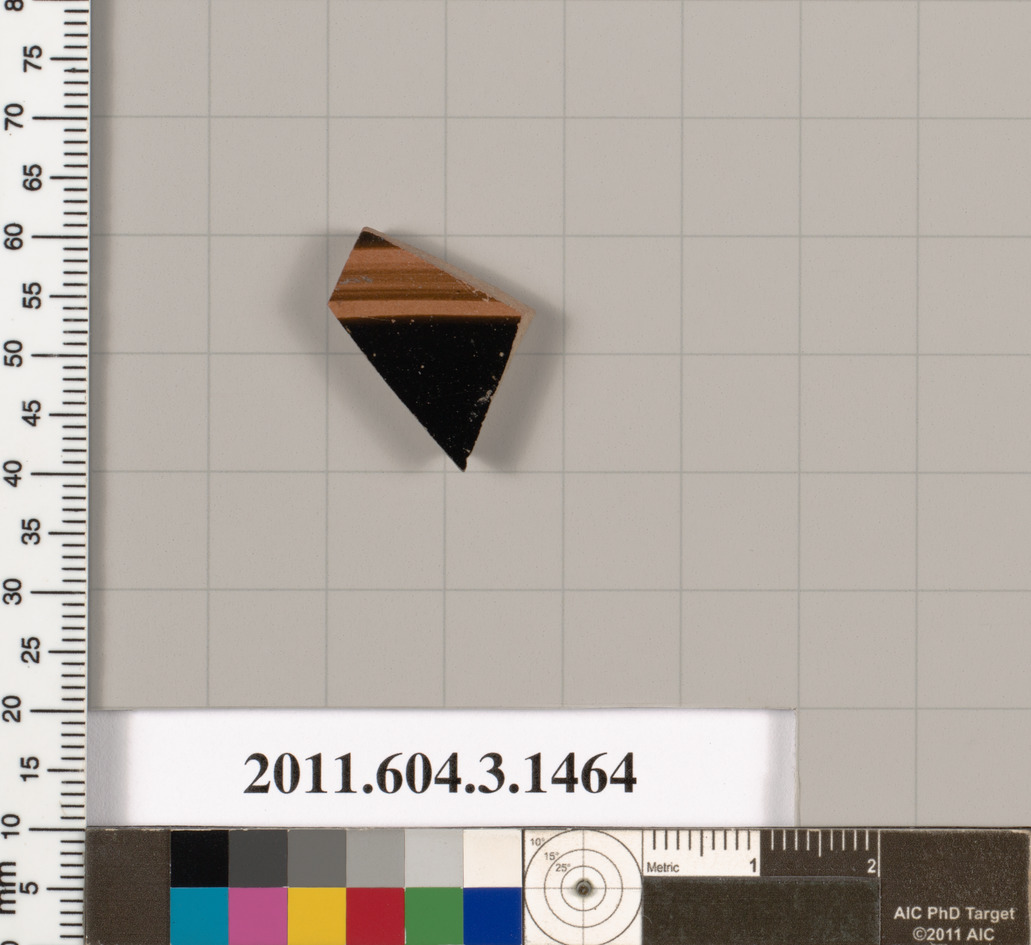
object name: skyphos fragment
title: Terracotta fragment of a skyphos (deep drinking cup)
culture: greek, attic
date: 600-401 BCE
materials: terracotta